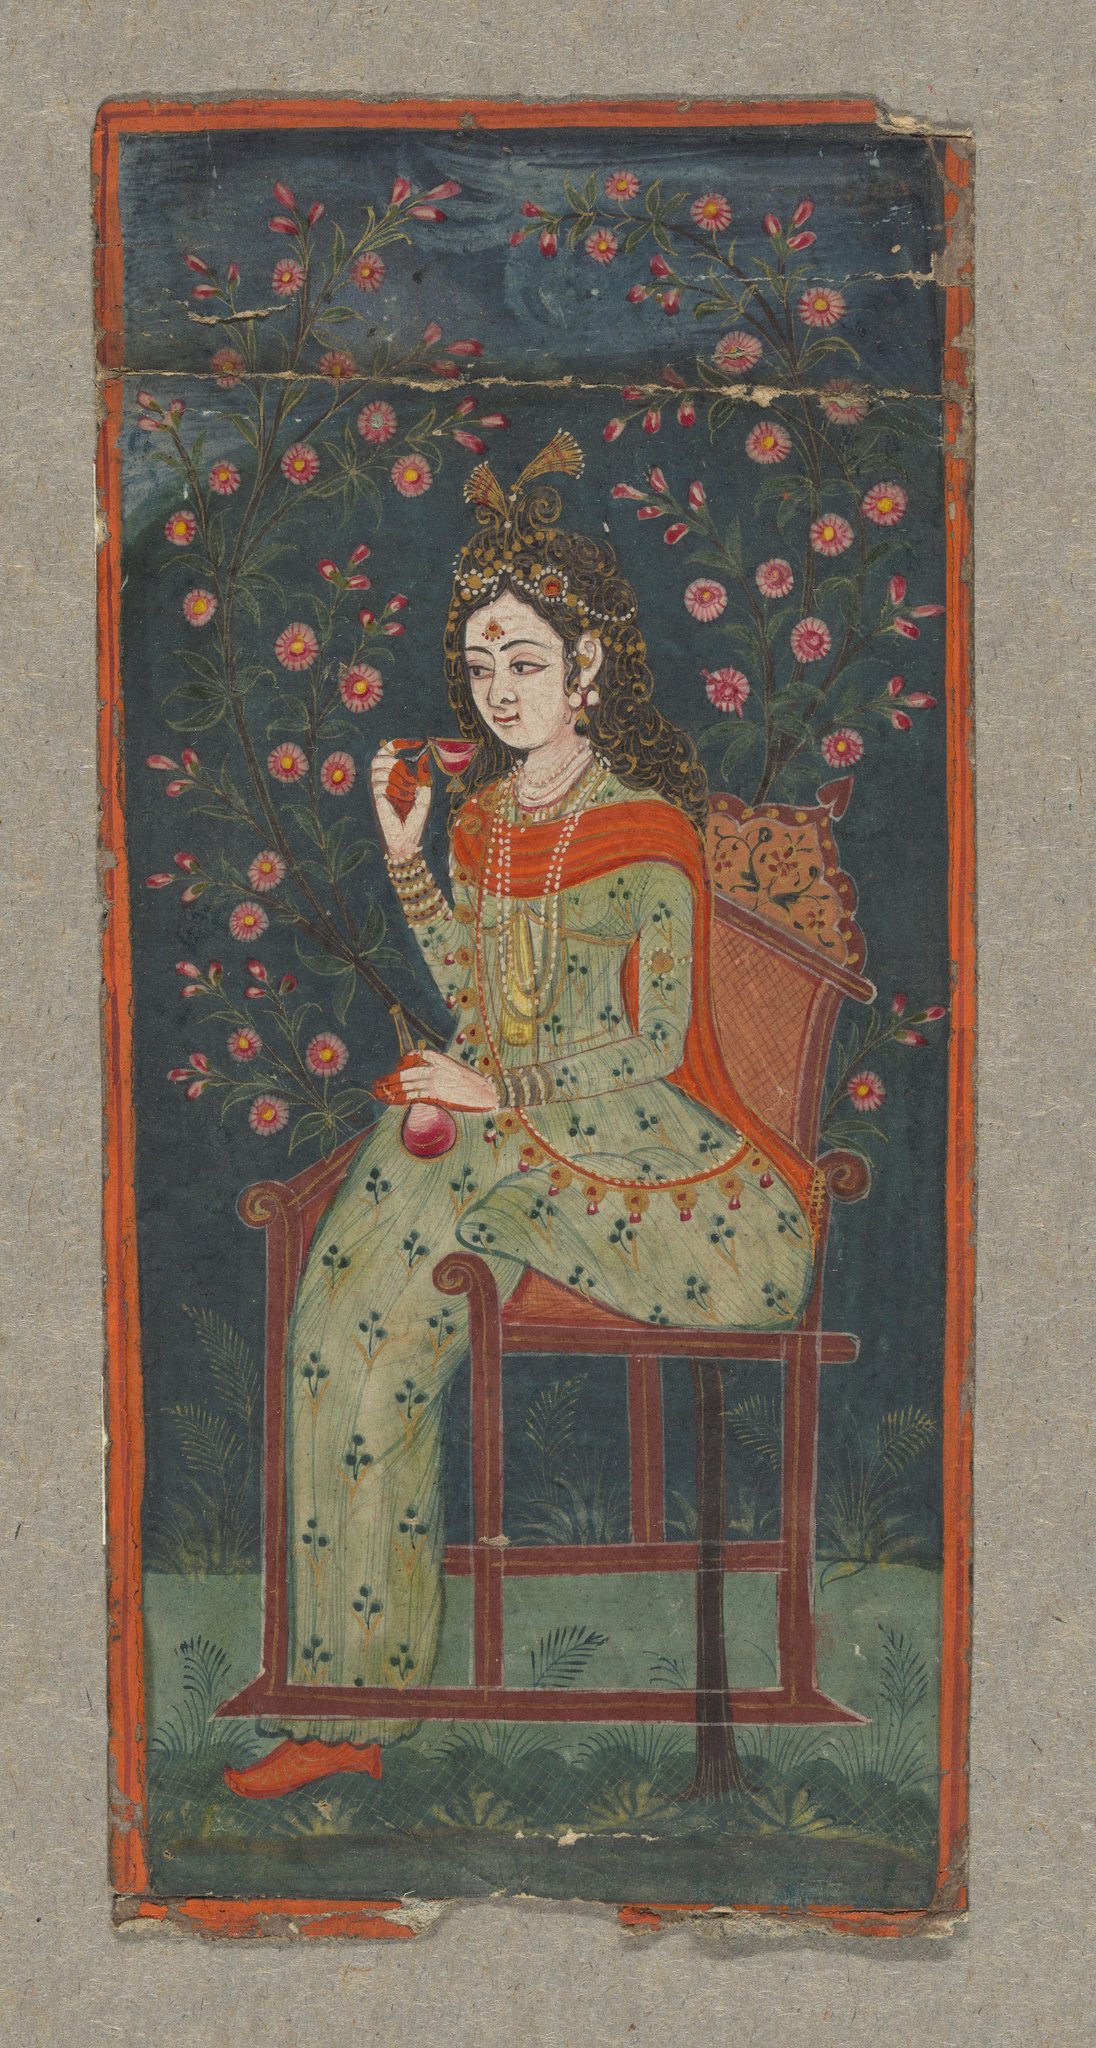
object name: indian miniature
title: Portrait of a seated Goan Lady with a cup and a flask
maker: Anonymous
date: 1700-1799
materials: paper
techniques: brush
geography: india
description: [Inscribed at the back “Her Picture”] Deccan 18th cent. (circa) Purchased from Mr E. Isacco, Galerie Marco Polo, Paris, 1976 Cf the painting c. 1610, in the Binney collection (San Diego),